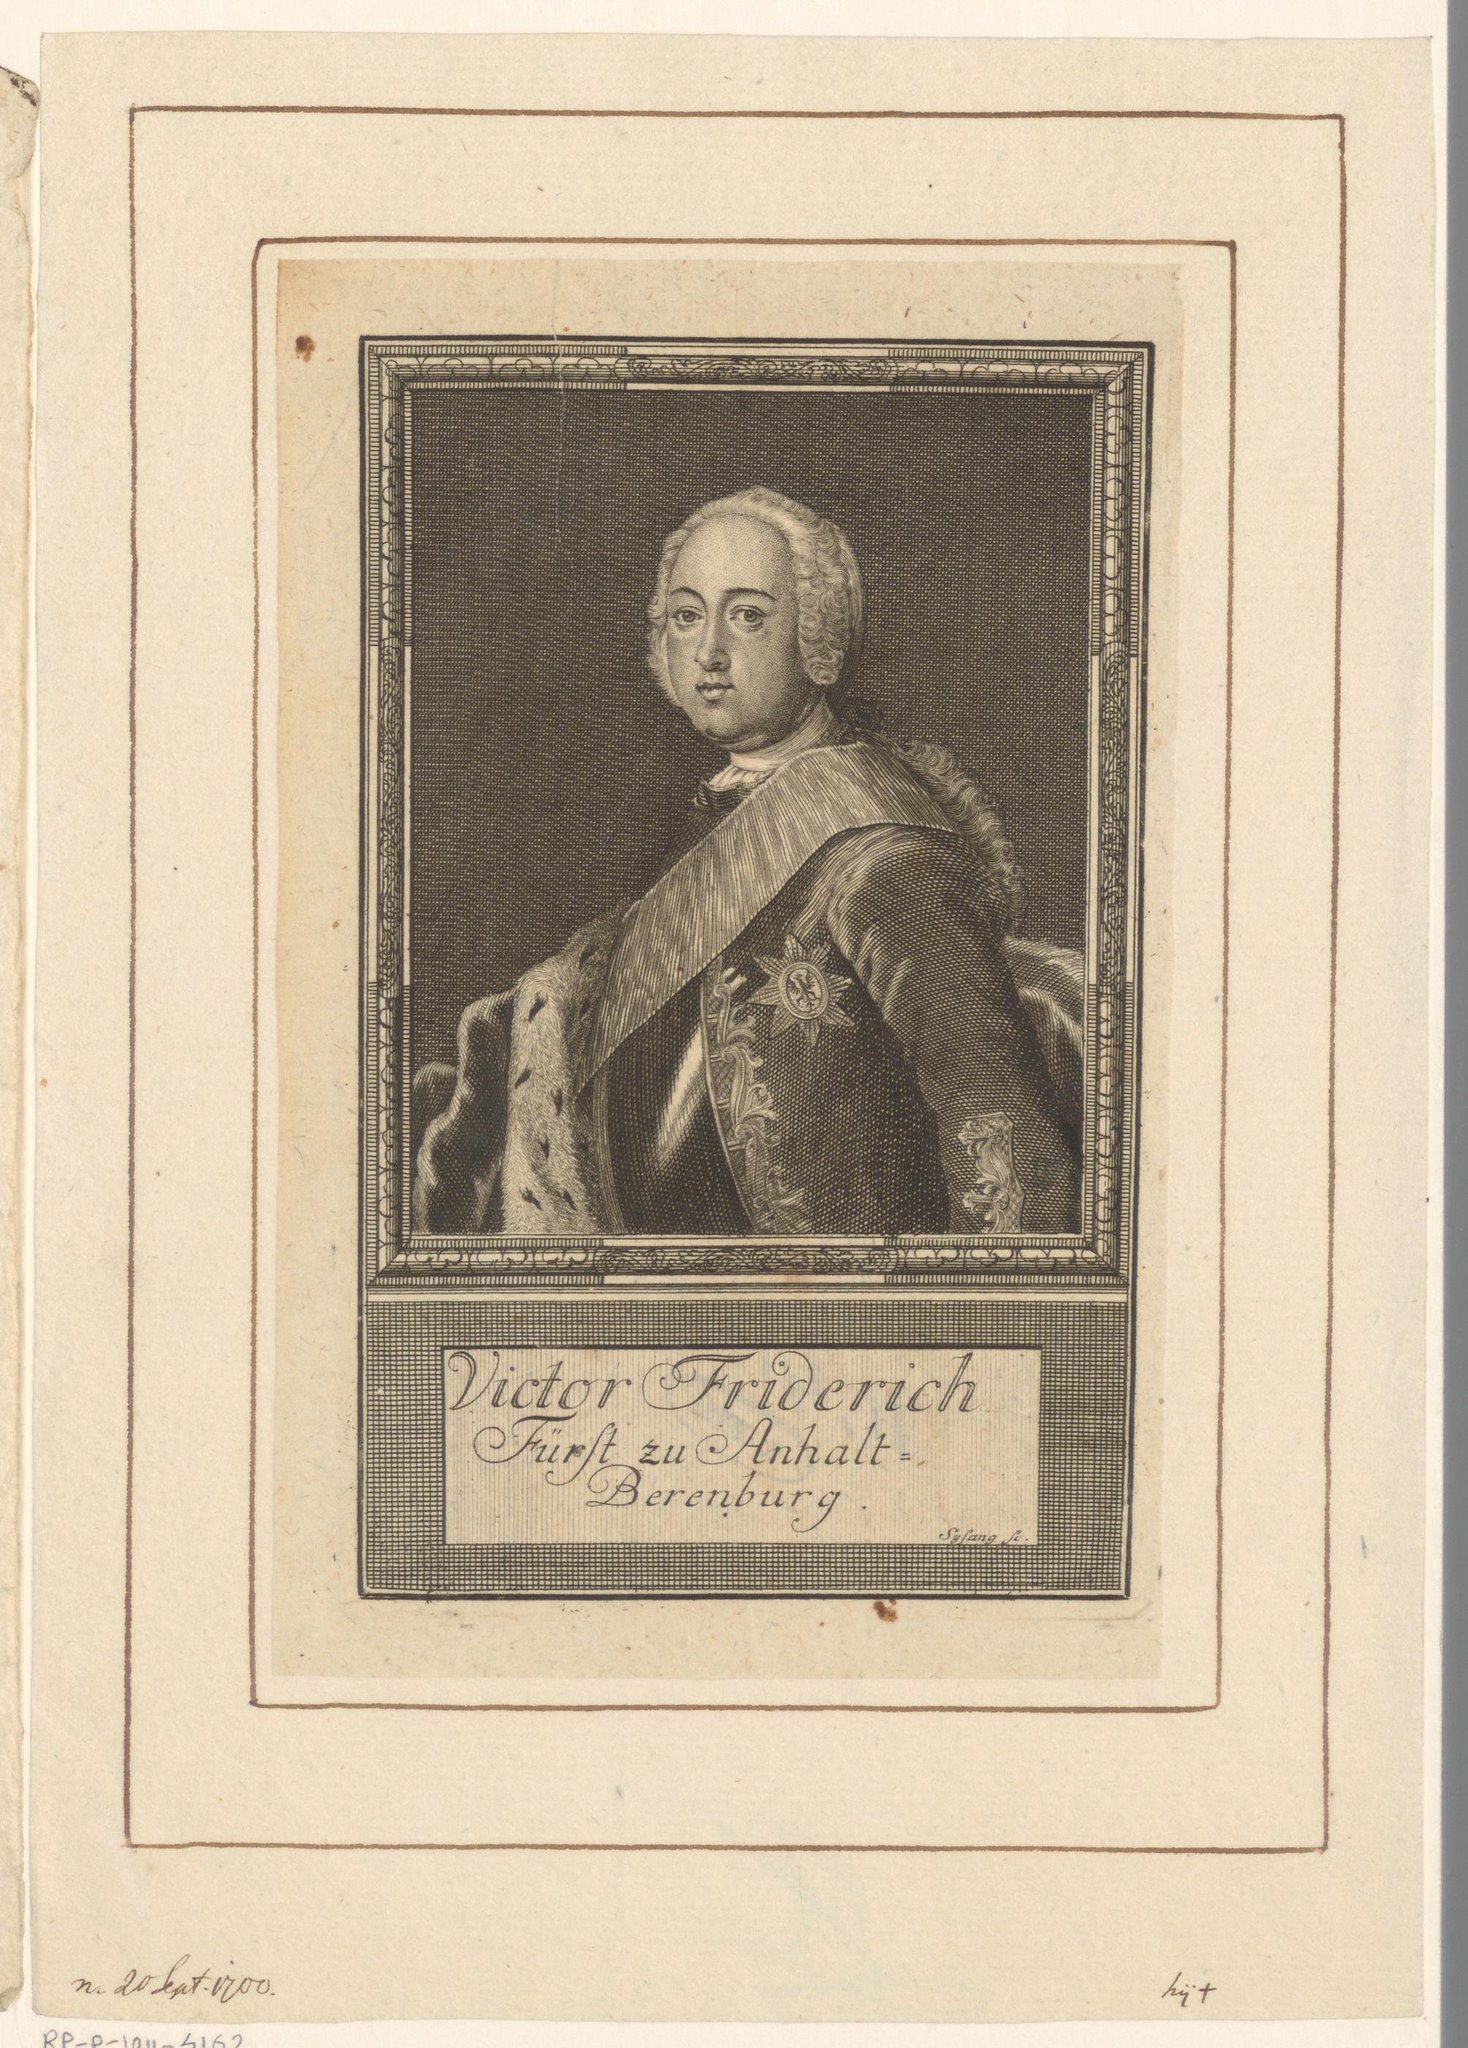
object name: print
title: Portret van Viktor Friedrich von Anhalt-Bernburg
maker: johann christoph sysang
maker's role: print maker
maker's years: 1703-1757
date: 1721-1757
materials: paper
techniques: engraving, etching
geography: germany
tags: historical persons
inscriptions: collector's mark: Lugt 2228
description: De prent is gemonteerd op een opzetvel voorzien van een dubbel kader met pen in bruin.